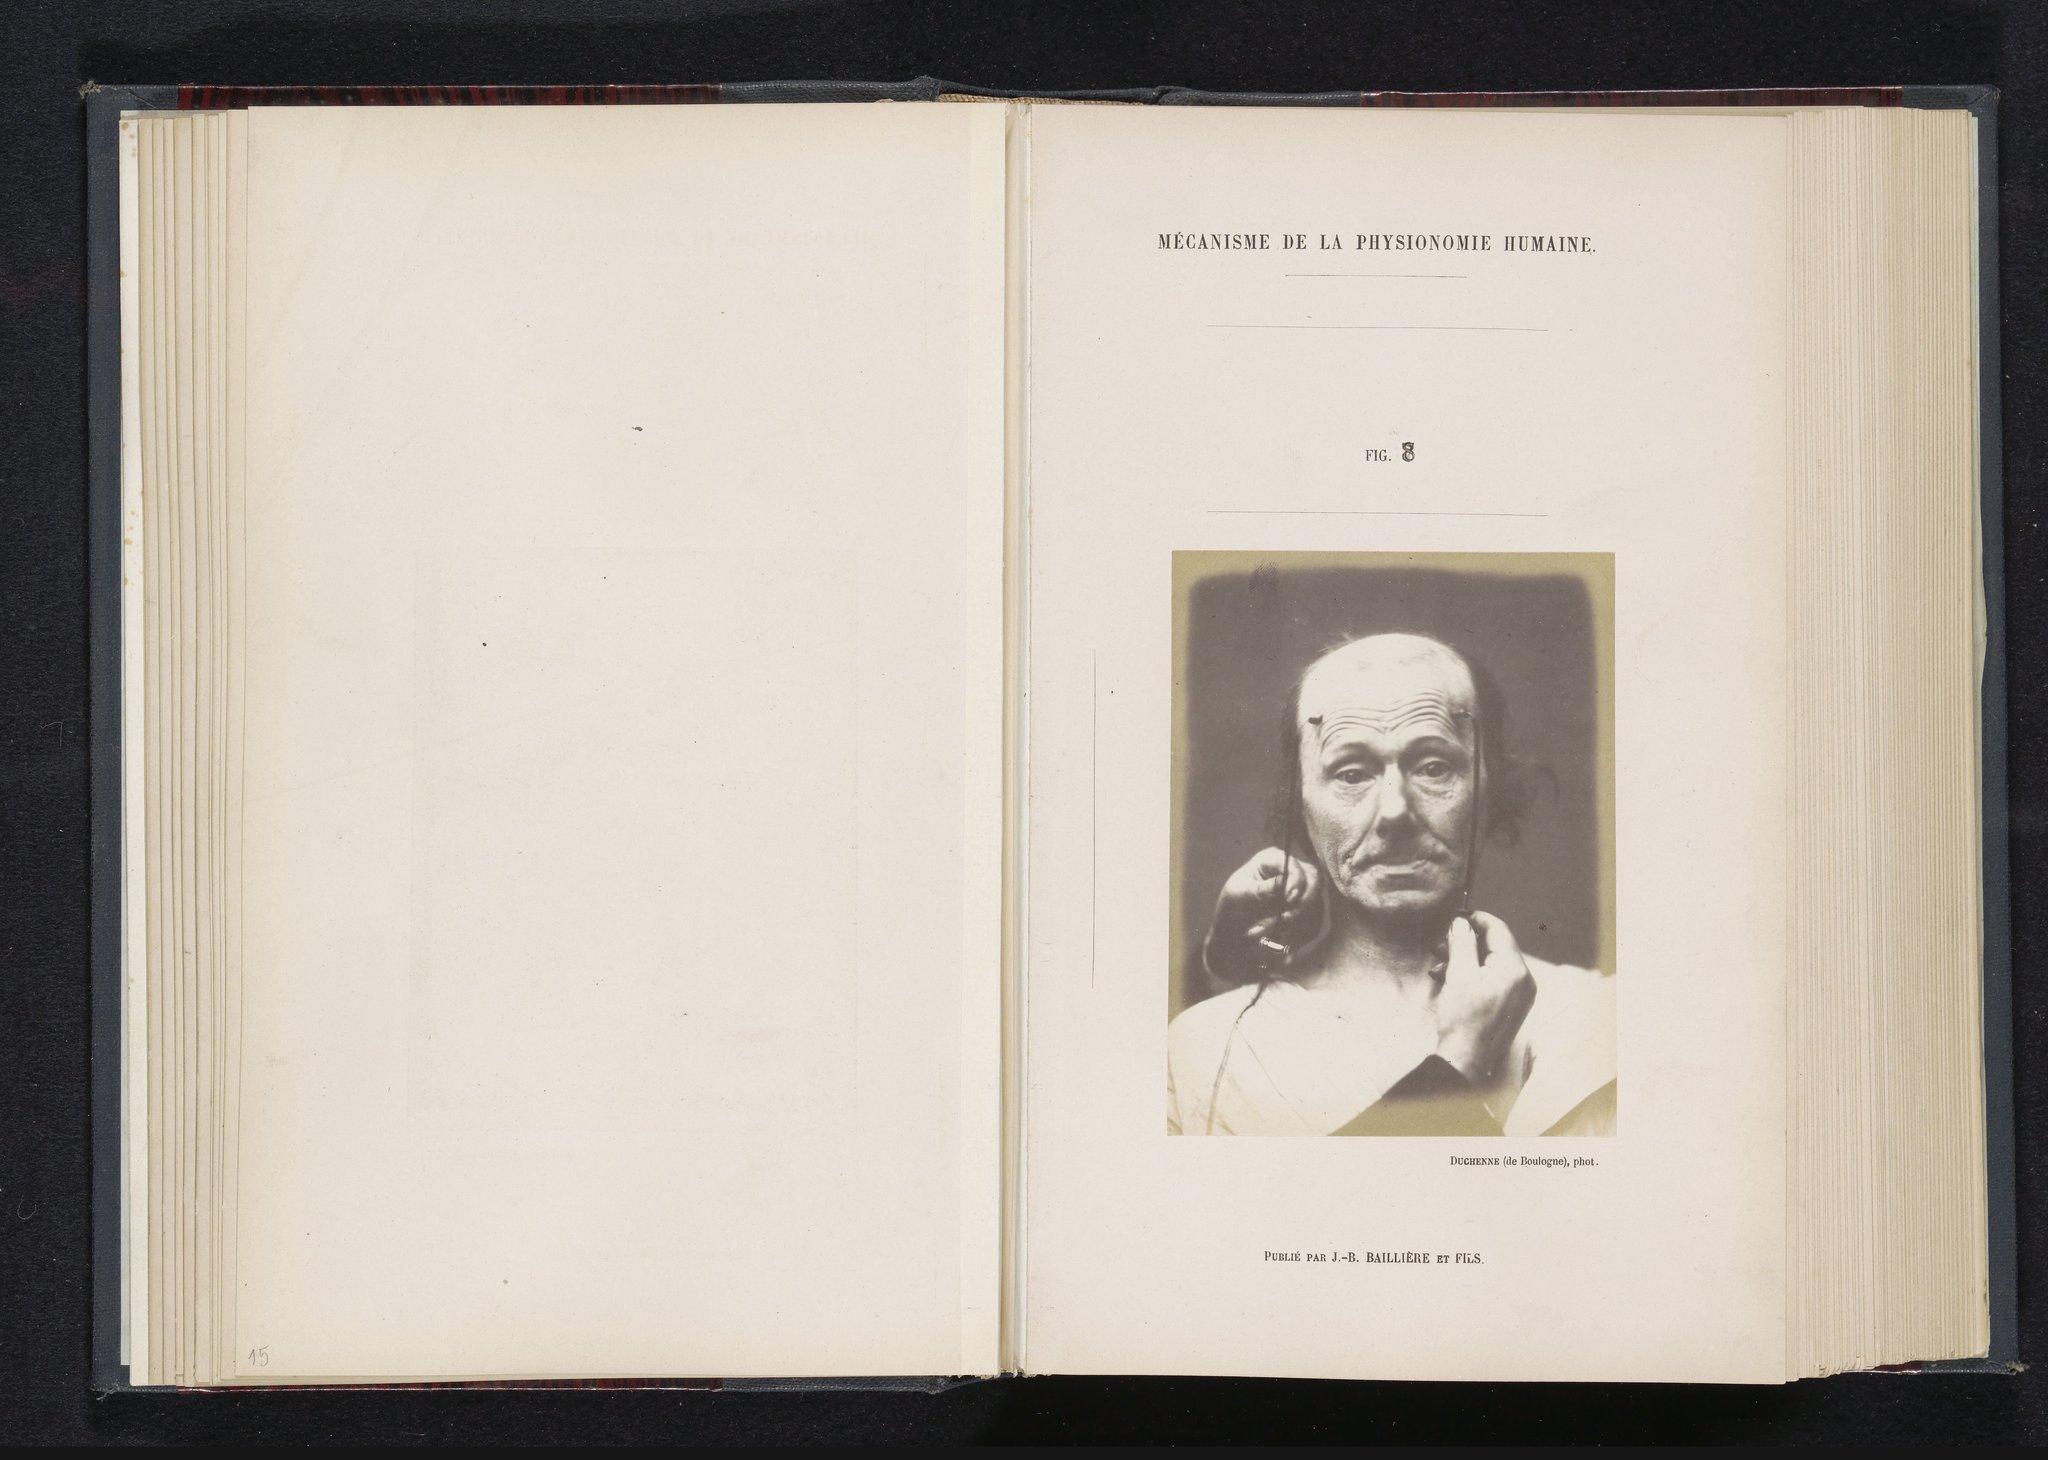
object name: photograph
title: Portret van een proefpersoon tijdens elektrostimulatie: 'un vieillard'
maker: guillaume benjamin amand duchenne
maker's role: fotograaf, medicus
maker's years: 1806-1875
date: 1860-1862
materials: paper, photographic support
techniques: albumen print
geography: paris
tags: face, physiology and anatomy ~ nervous system, neurology, physiology and anatomy, old man, morphology of facial expression, physiognomy, experiment, test ~ science and technology, france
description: Ongenummerde pagina met foto 8 uit Mécanisme de la physionomie humaine ou analyse électro-physiologique de l'expression des passions (Atlas).